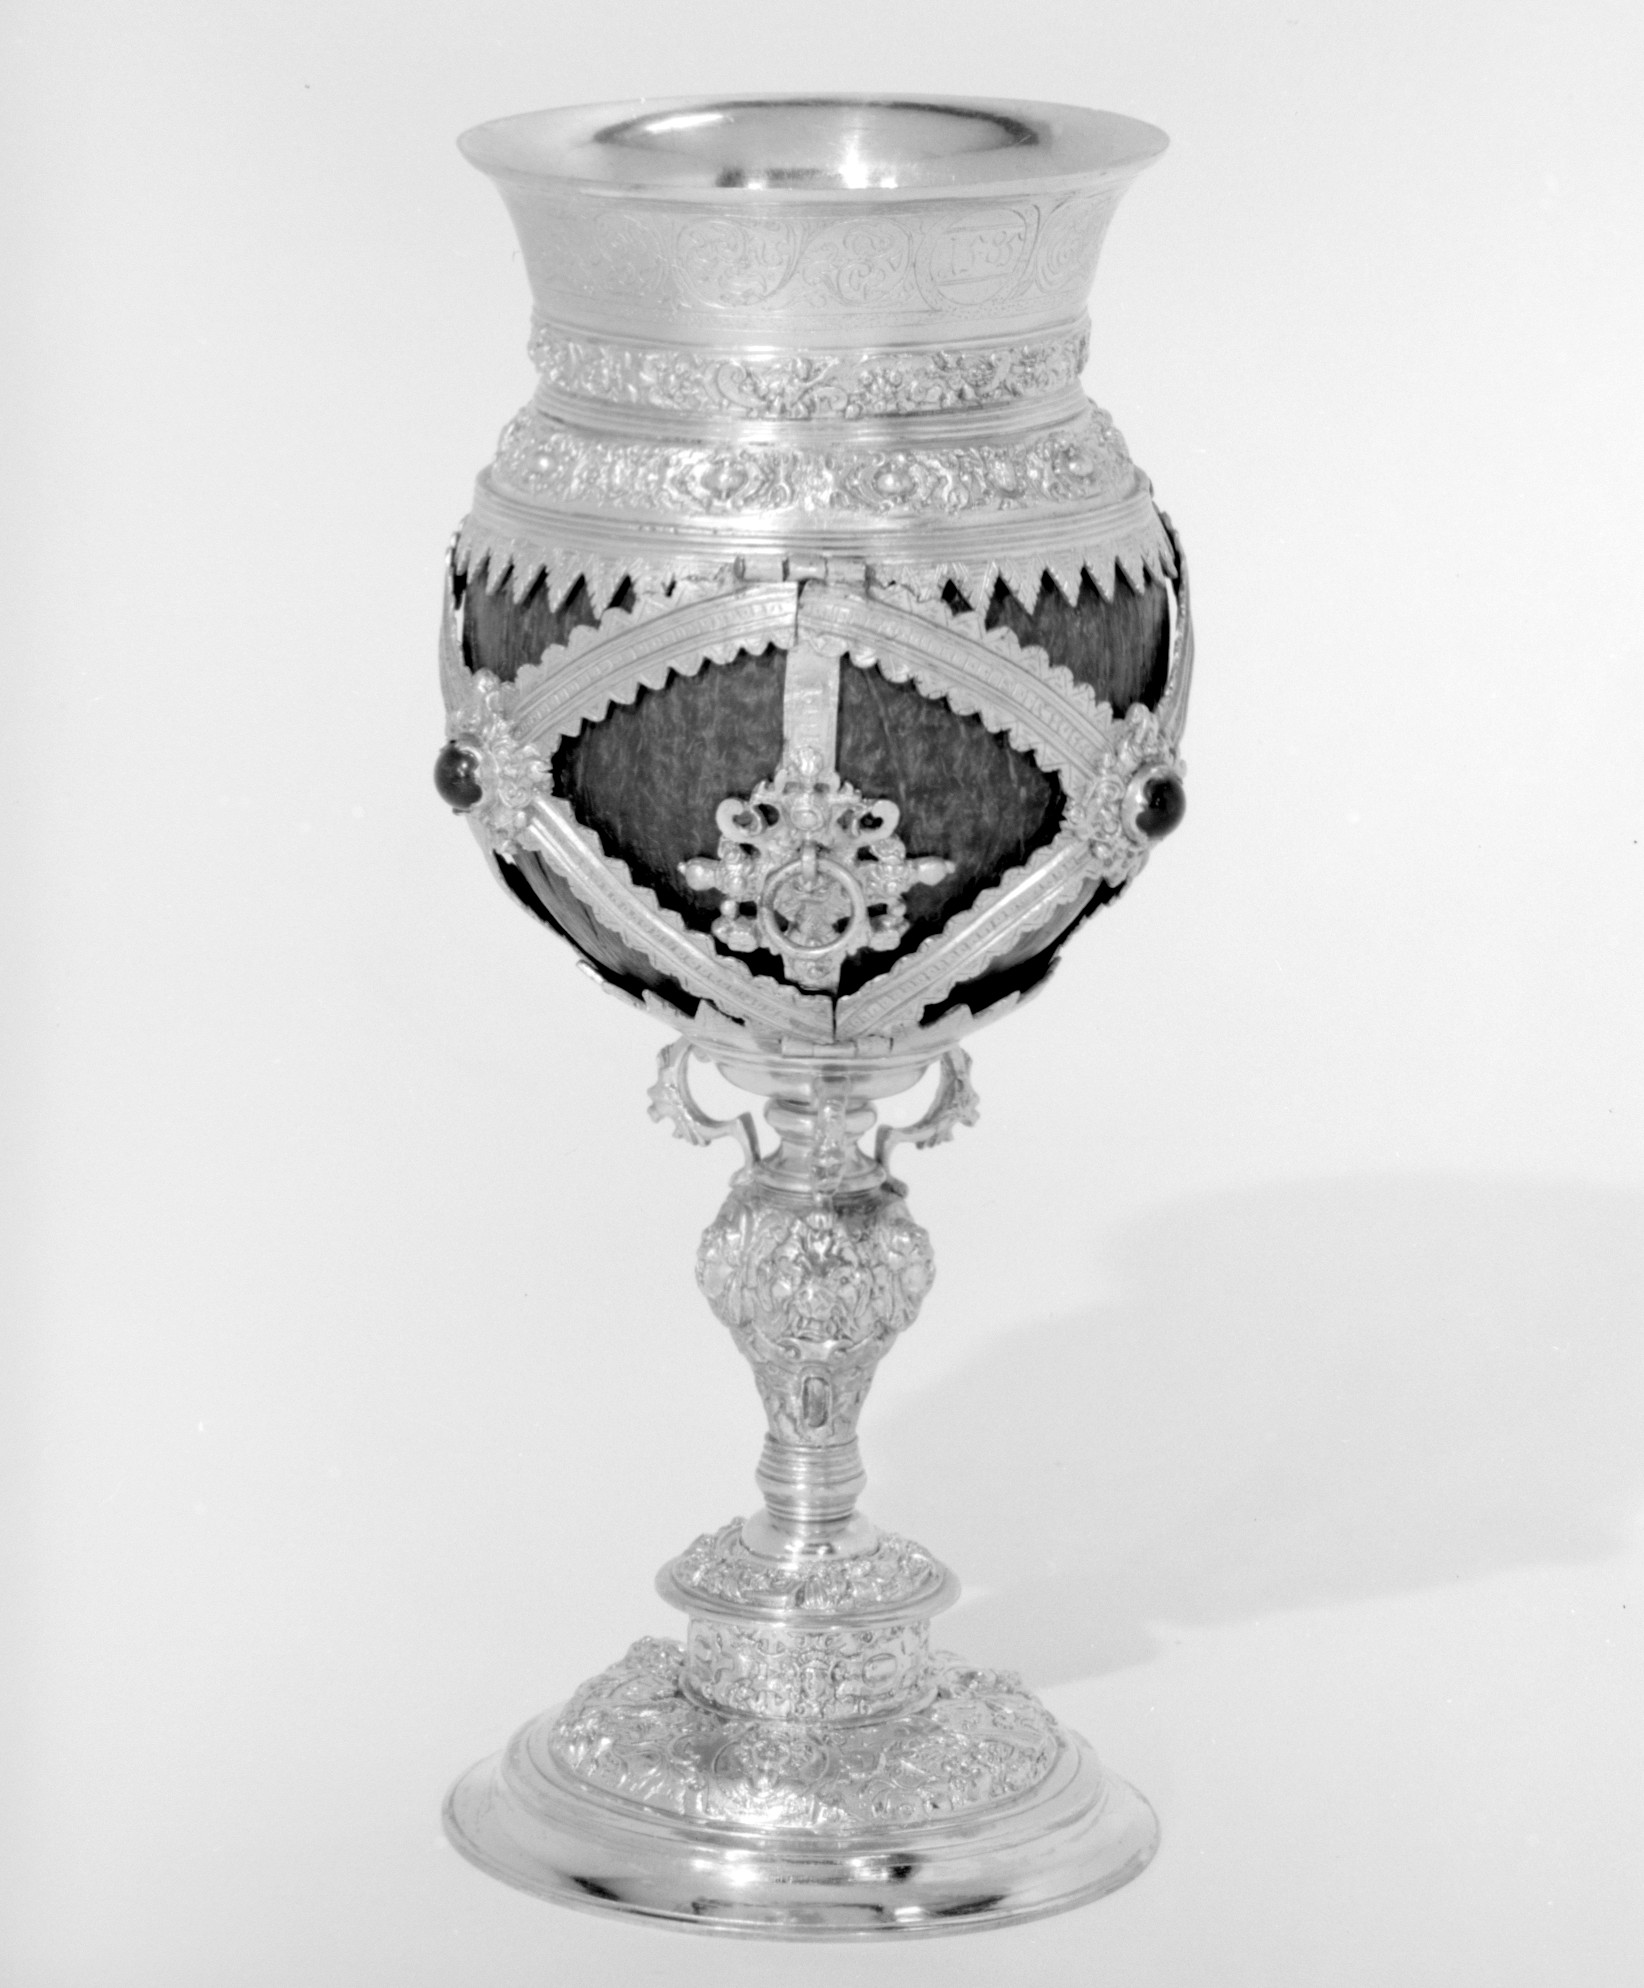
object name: cup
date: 1801-1900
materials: metal, silver